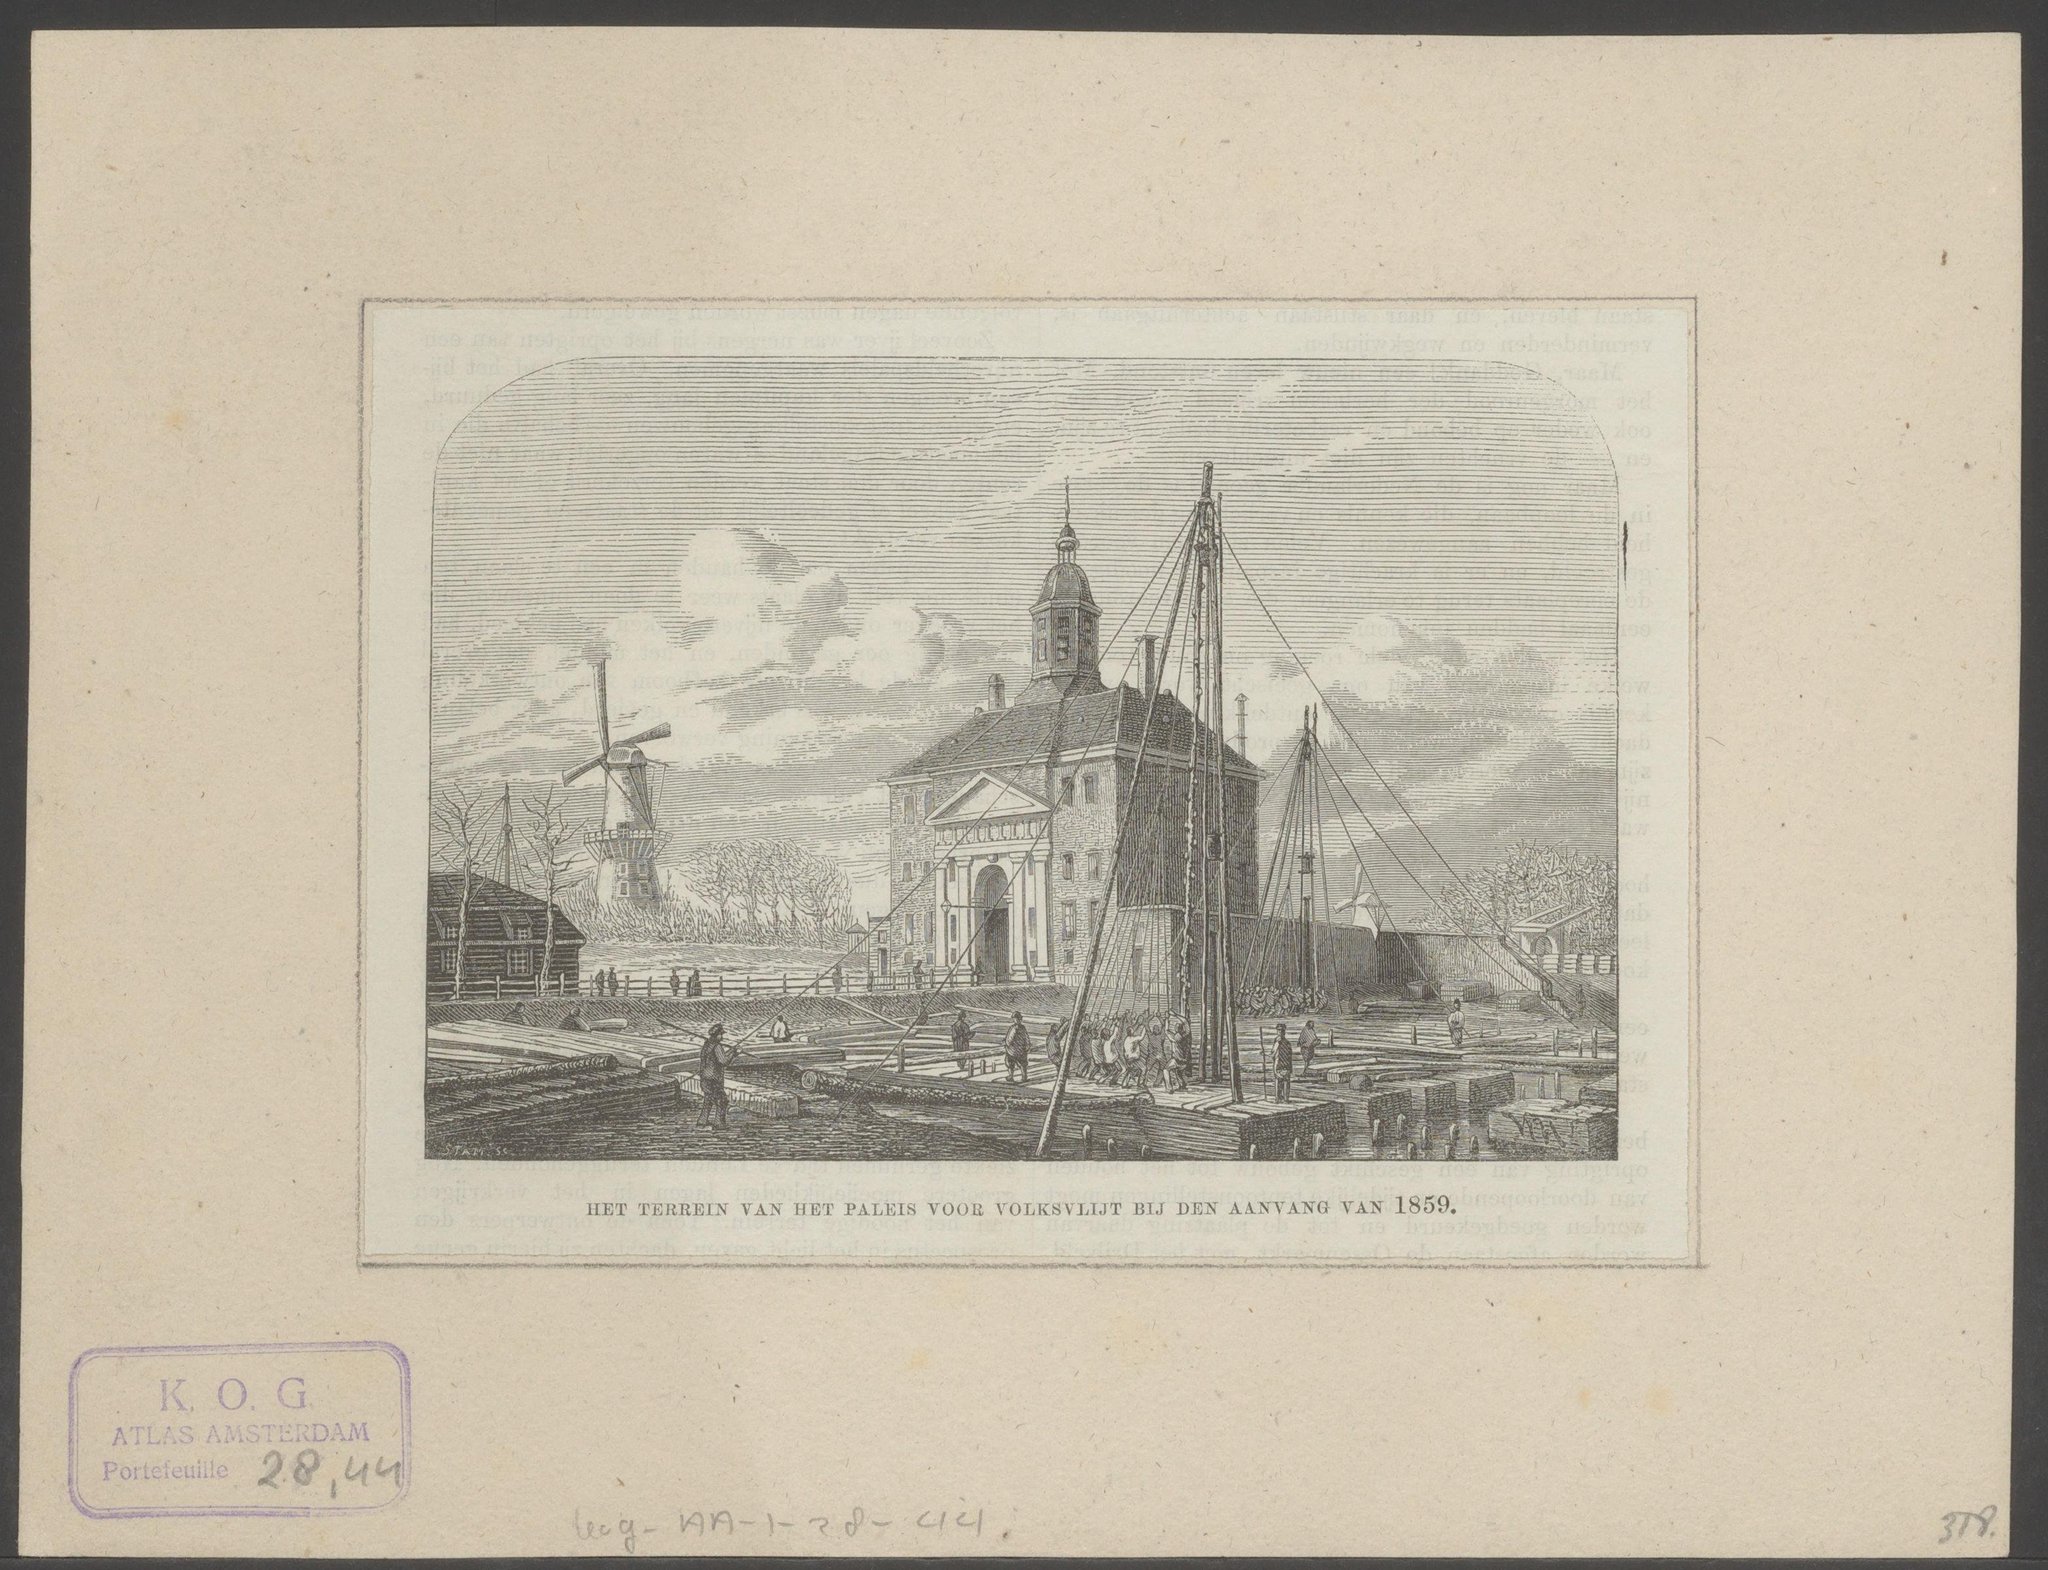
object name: print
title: Gezicht op de Utrechtsepoort te Amsterdam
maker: willem hendrik stam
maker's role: print maker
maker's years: 1831-1874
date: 1859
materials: paper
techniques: letterpress printing, engraving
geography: amsterdam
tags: building-site, windmill, city-gate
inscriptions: collector's mark: Lugt 1641b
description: Gezicht op de Utrechtsepoort te Amsterdam. Deze poort stond op het terrein waar later het Paleis voor Volksvlijt werd gebouwd. Onderwerpsrubriek binnen de Atlas Amsterdam: Poorten, verzamelbladen, C. Utrechtse Poort.